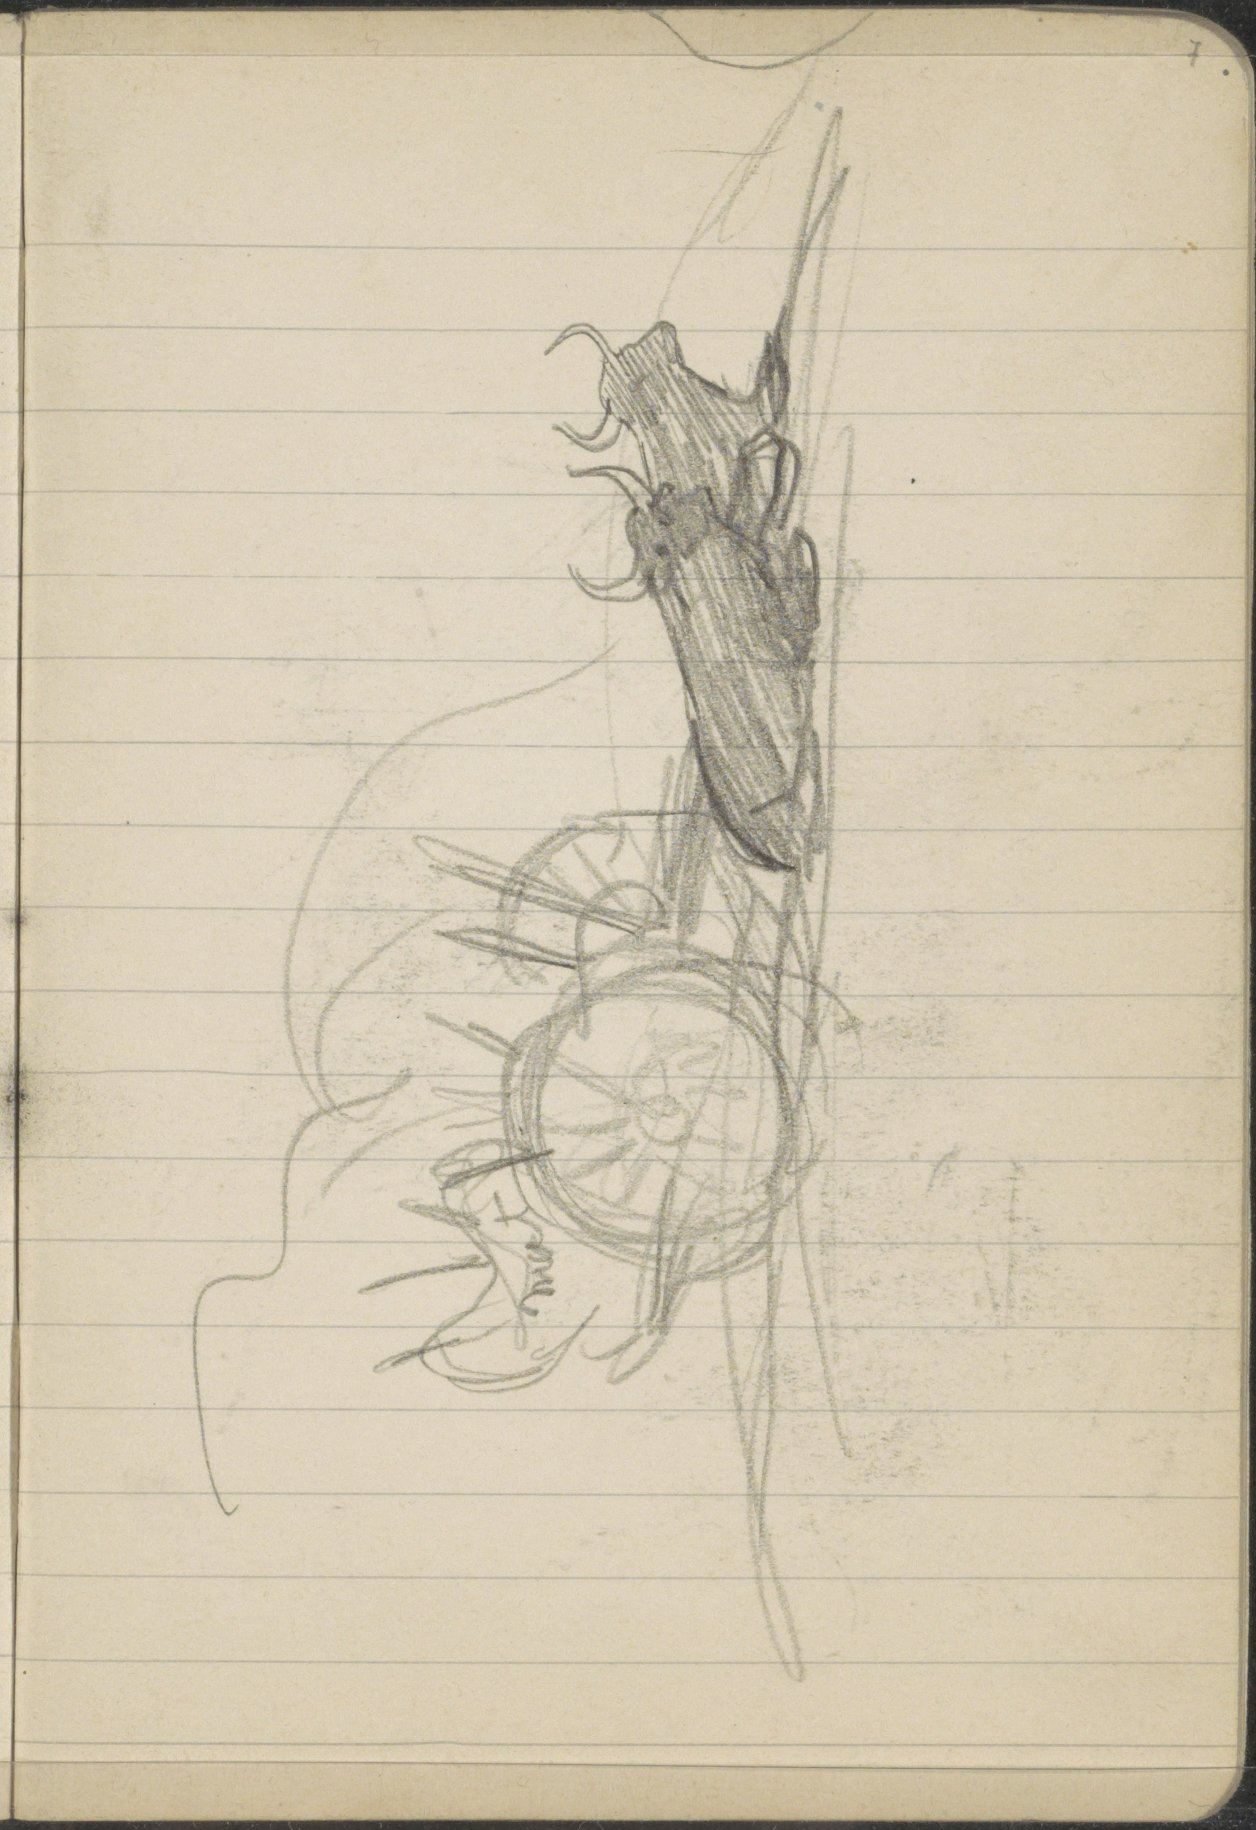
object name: sketchbook leaf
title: Liggende ossen voor een kar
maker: marius bauer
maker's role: draughtsman, print maker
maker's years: 1867-1932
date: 1902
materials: pencil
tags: ox, (farm) wagon, freight wagon, cart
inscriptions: kleurnotitie, handgeschreven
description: Pagina 7 uit een schetsboek met 50 bladen.